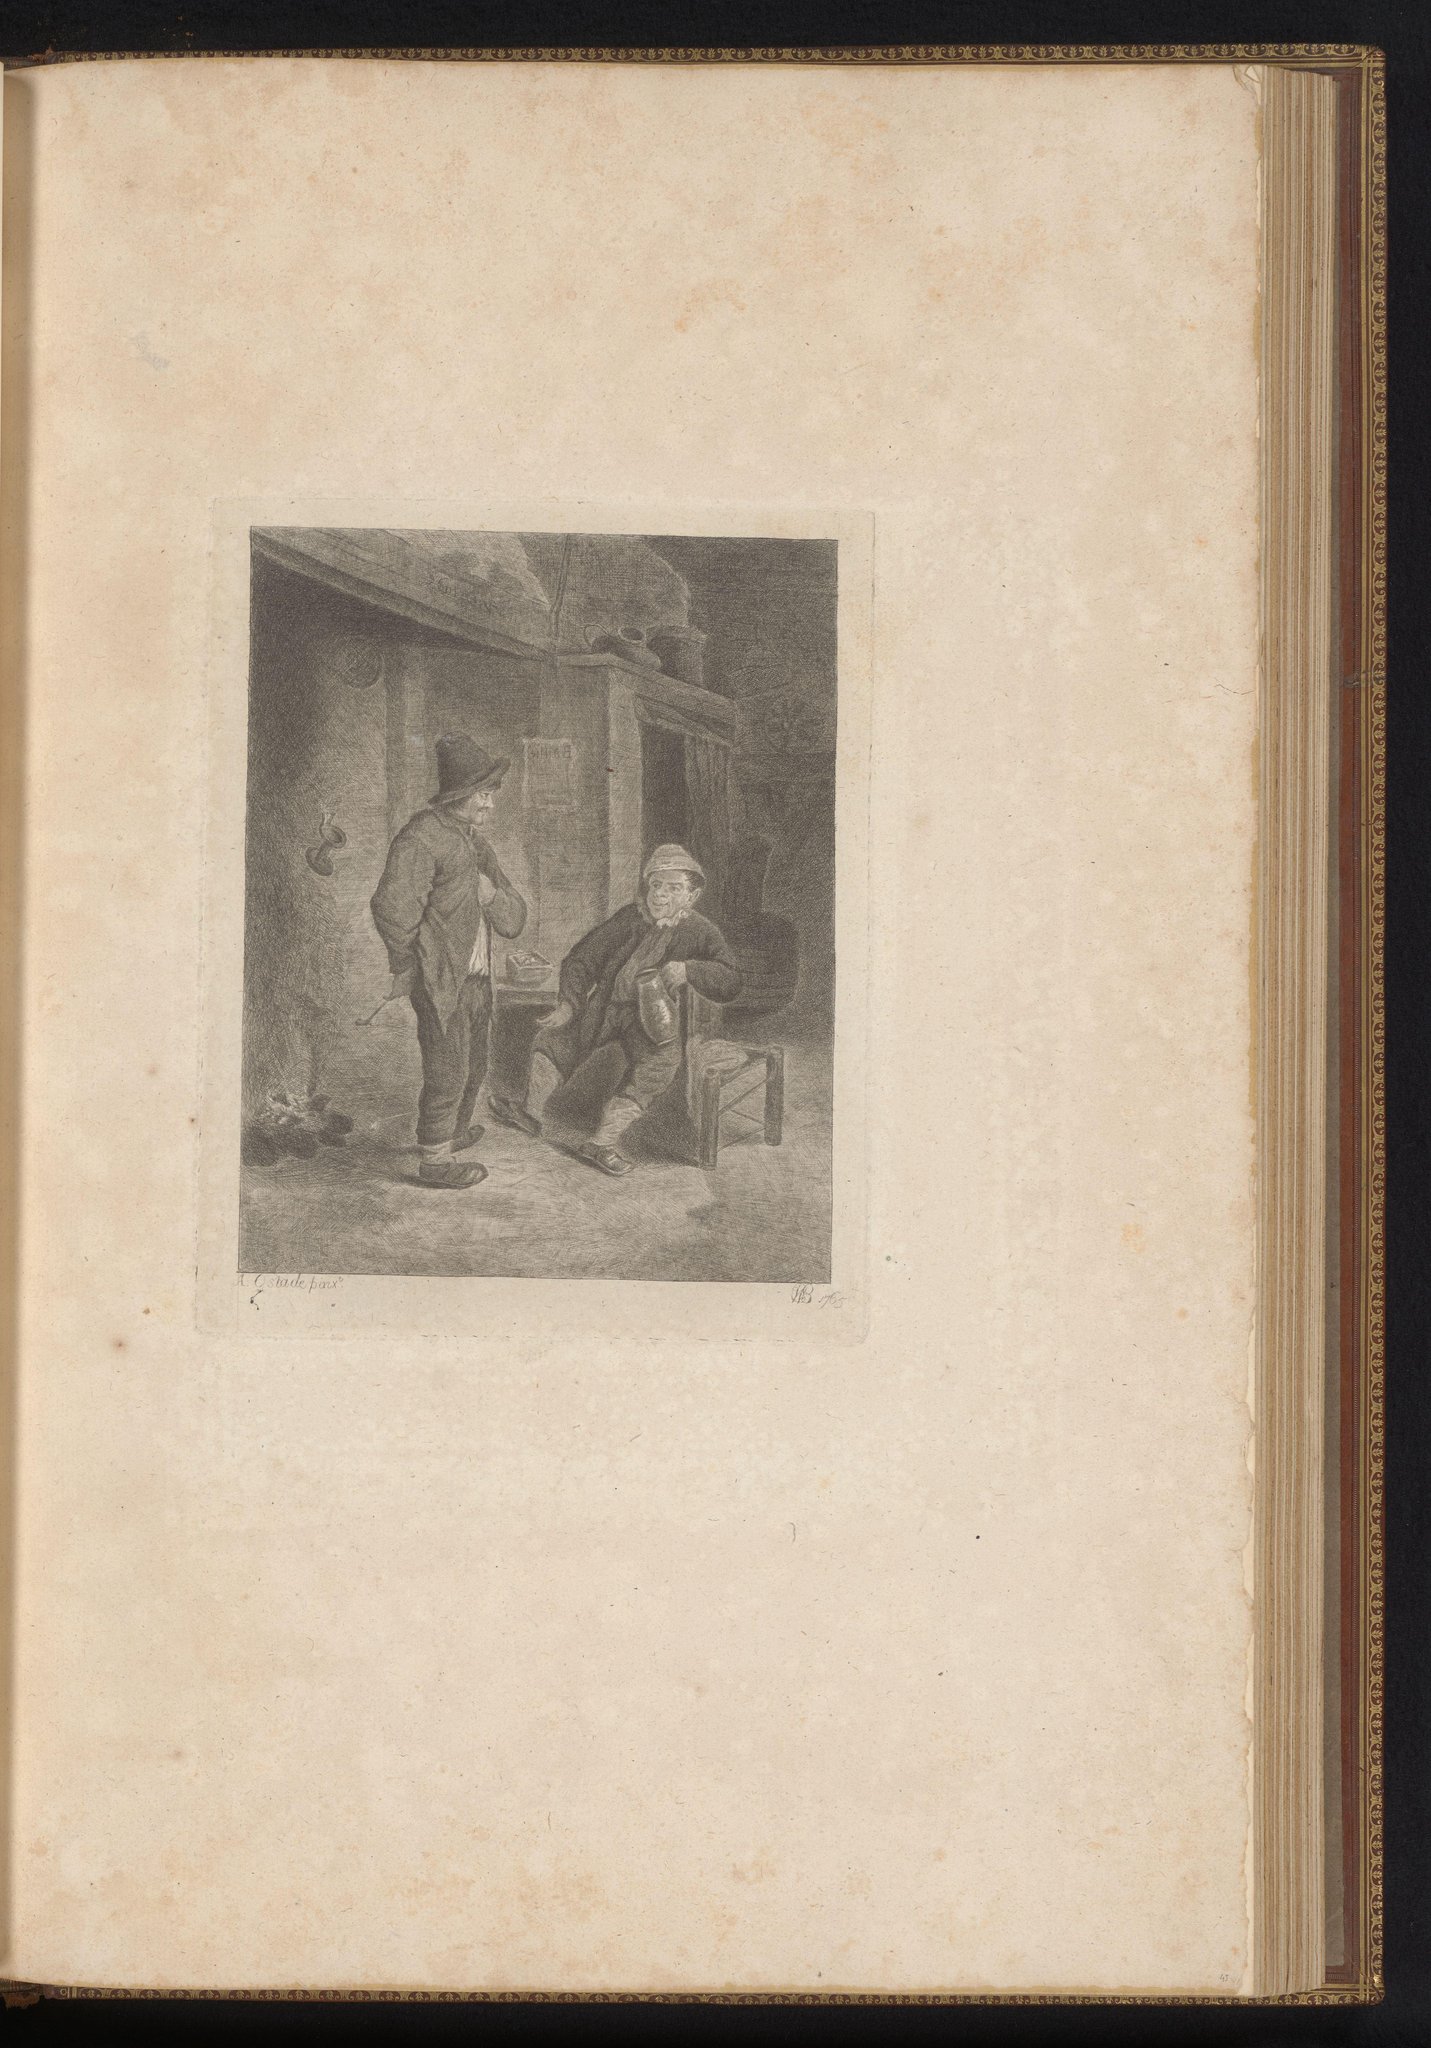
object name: print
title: Interieur met twee boeren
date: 1765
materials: paper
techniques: etching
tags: farmers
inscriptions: date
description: Interieur met twee boeren. De ene boer met een pijp in zijn handen. De andere boer met kruik. De prent maakt deel uit van een album.